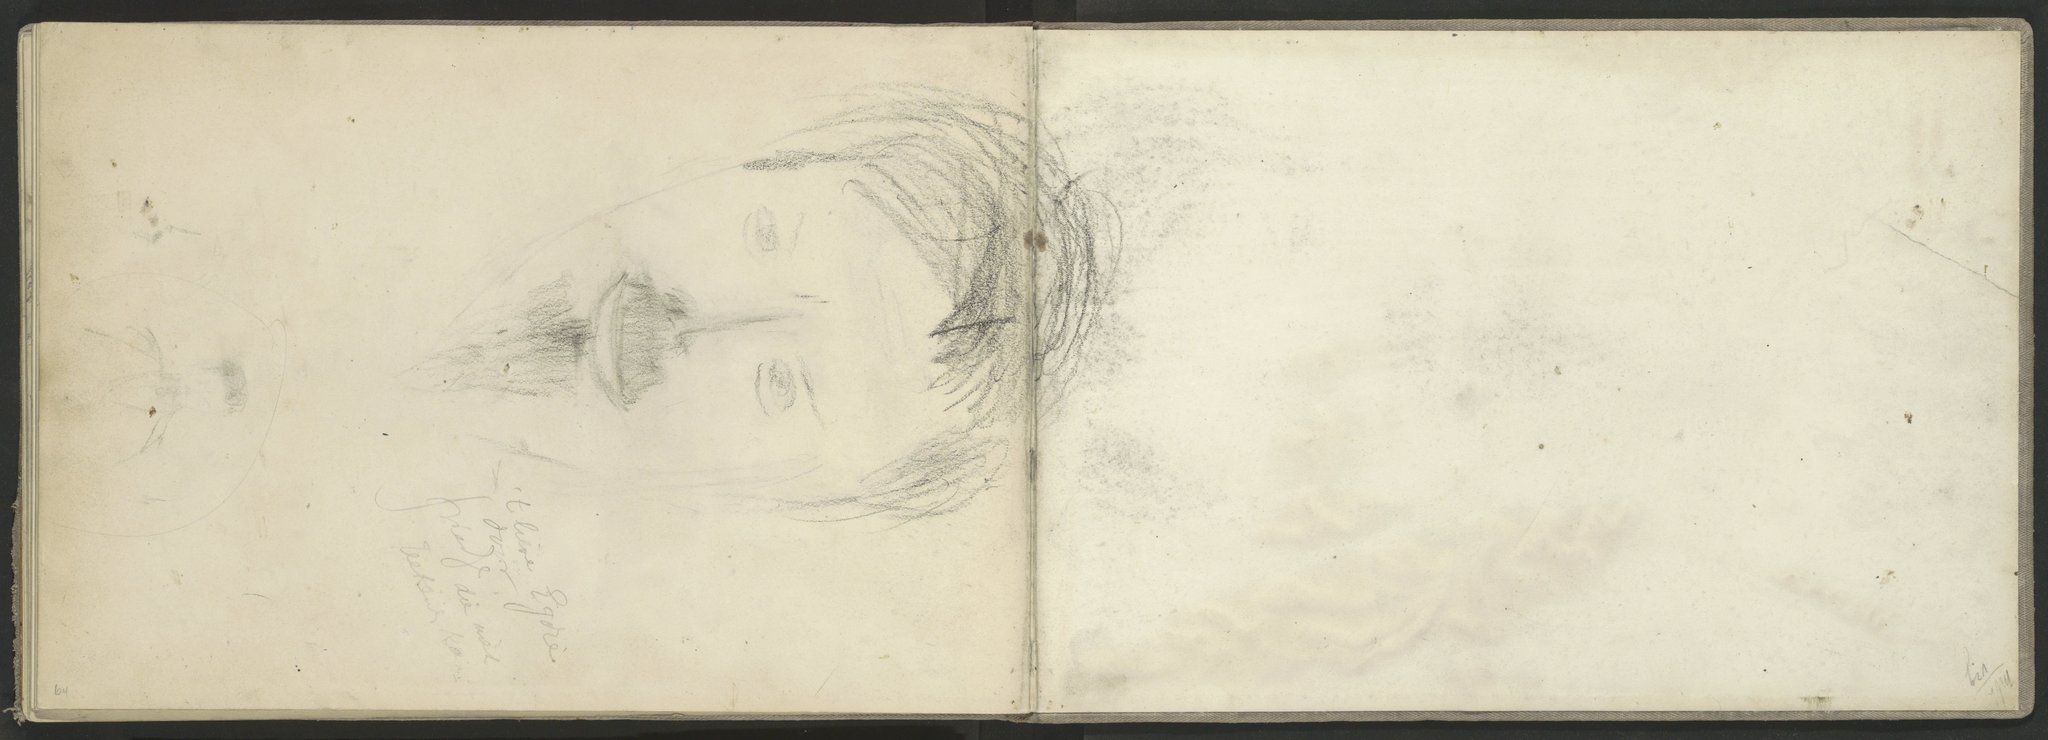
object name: sketchbook leaf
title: Portret van een man met sik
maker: egbert rubertus derk schaap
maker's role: draughtsman, painter, print maker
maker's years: 1862-1939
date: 1891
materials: chalk, paper, pencil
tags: anonymous historical person portrayed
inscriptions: annotation: ‘'t lieve Egore?/ door/ We[...]/ die wèl/ teekene kan’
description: Pagina 64 en het achterste schutblad uit een schetsboek met 64 pagina's.